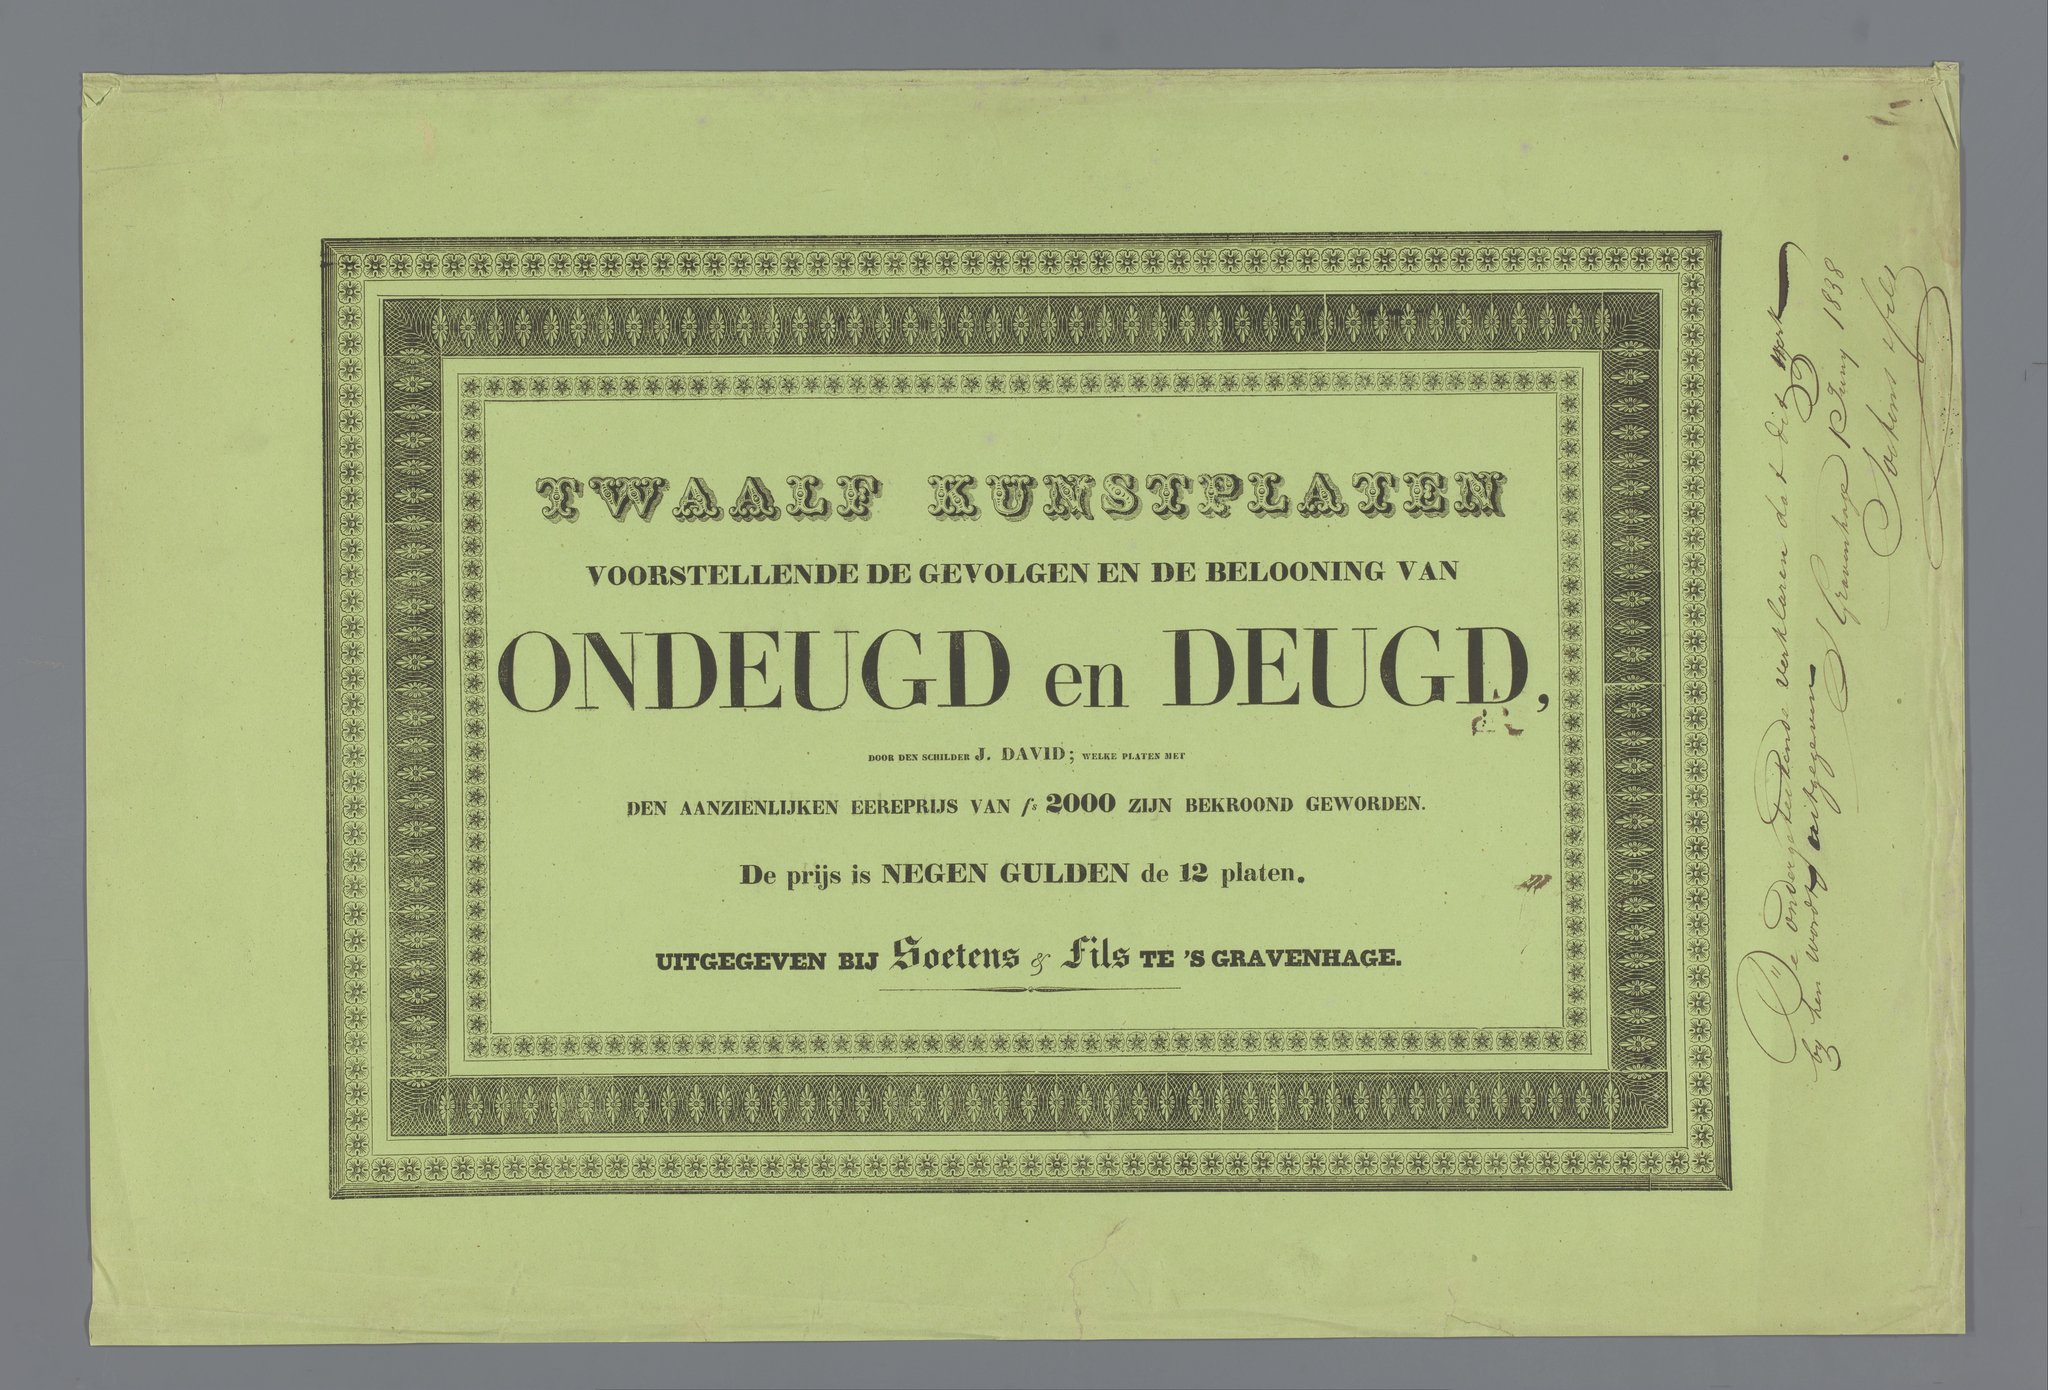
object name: print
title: Twaalf kunstplaten voorstellende de gevolgen en de belooning van ondeugd en deugd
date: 1837-1840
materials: paper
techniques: letterpress printing, lithograph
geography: the hague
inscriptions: collector's mark: Lugt 2228, : ‘De ondergetekende verklaren dat dit werk / bij hen wordt uitgegeven / S Gravenhage 1 Juny 1838 / Soetens Fils’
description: Op de achterkant de titels van de twaalf prenten met een toelichting. Omslag met zes prenten.